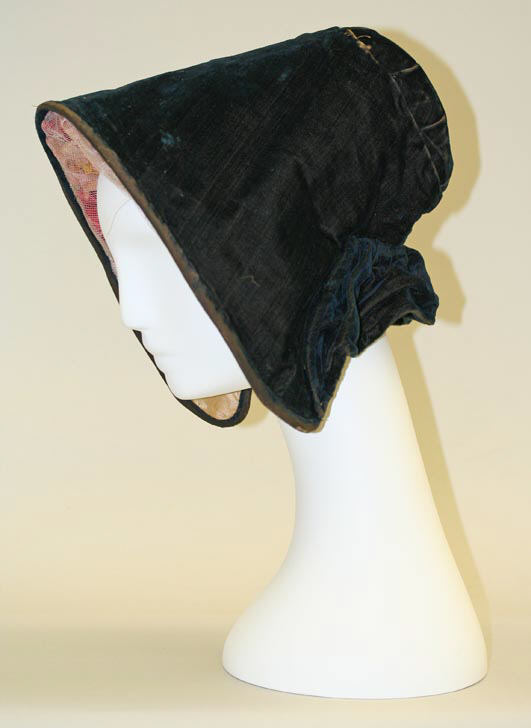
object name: poke bonnet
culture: american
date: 1845-1855